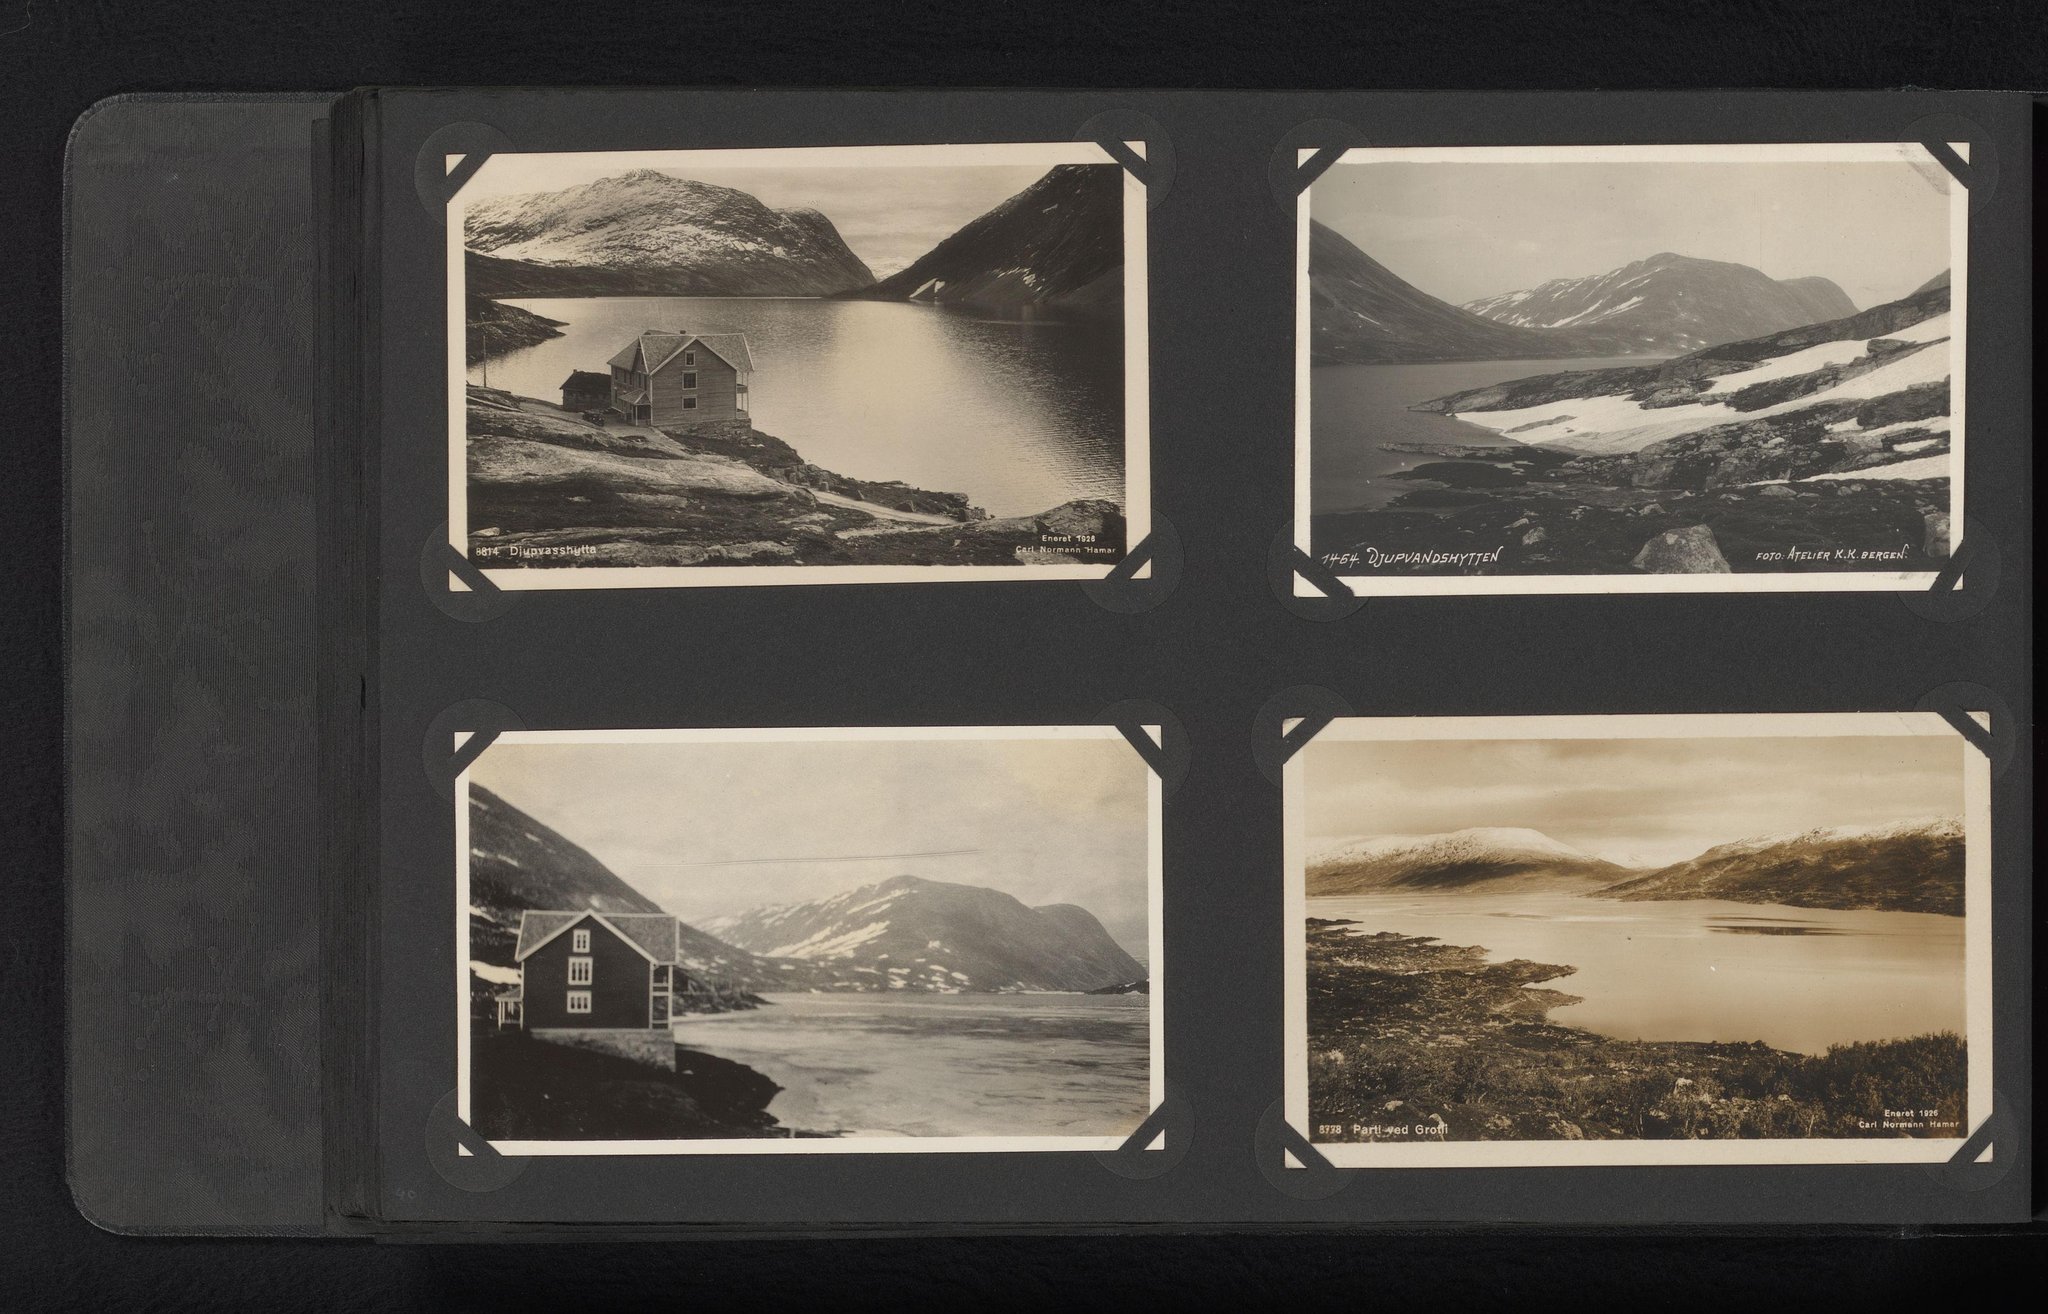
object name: photograph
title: Vier foto's, waarvan drie prentbriefkaarten, van Djupvasshytta en Djupvatnet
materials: paper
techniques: gelatin silver print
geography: møre og romsdal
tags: lake, hotel, hostelry, inn, mountains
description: Deze foto's maken deel uit van een album.